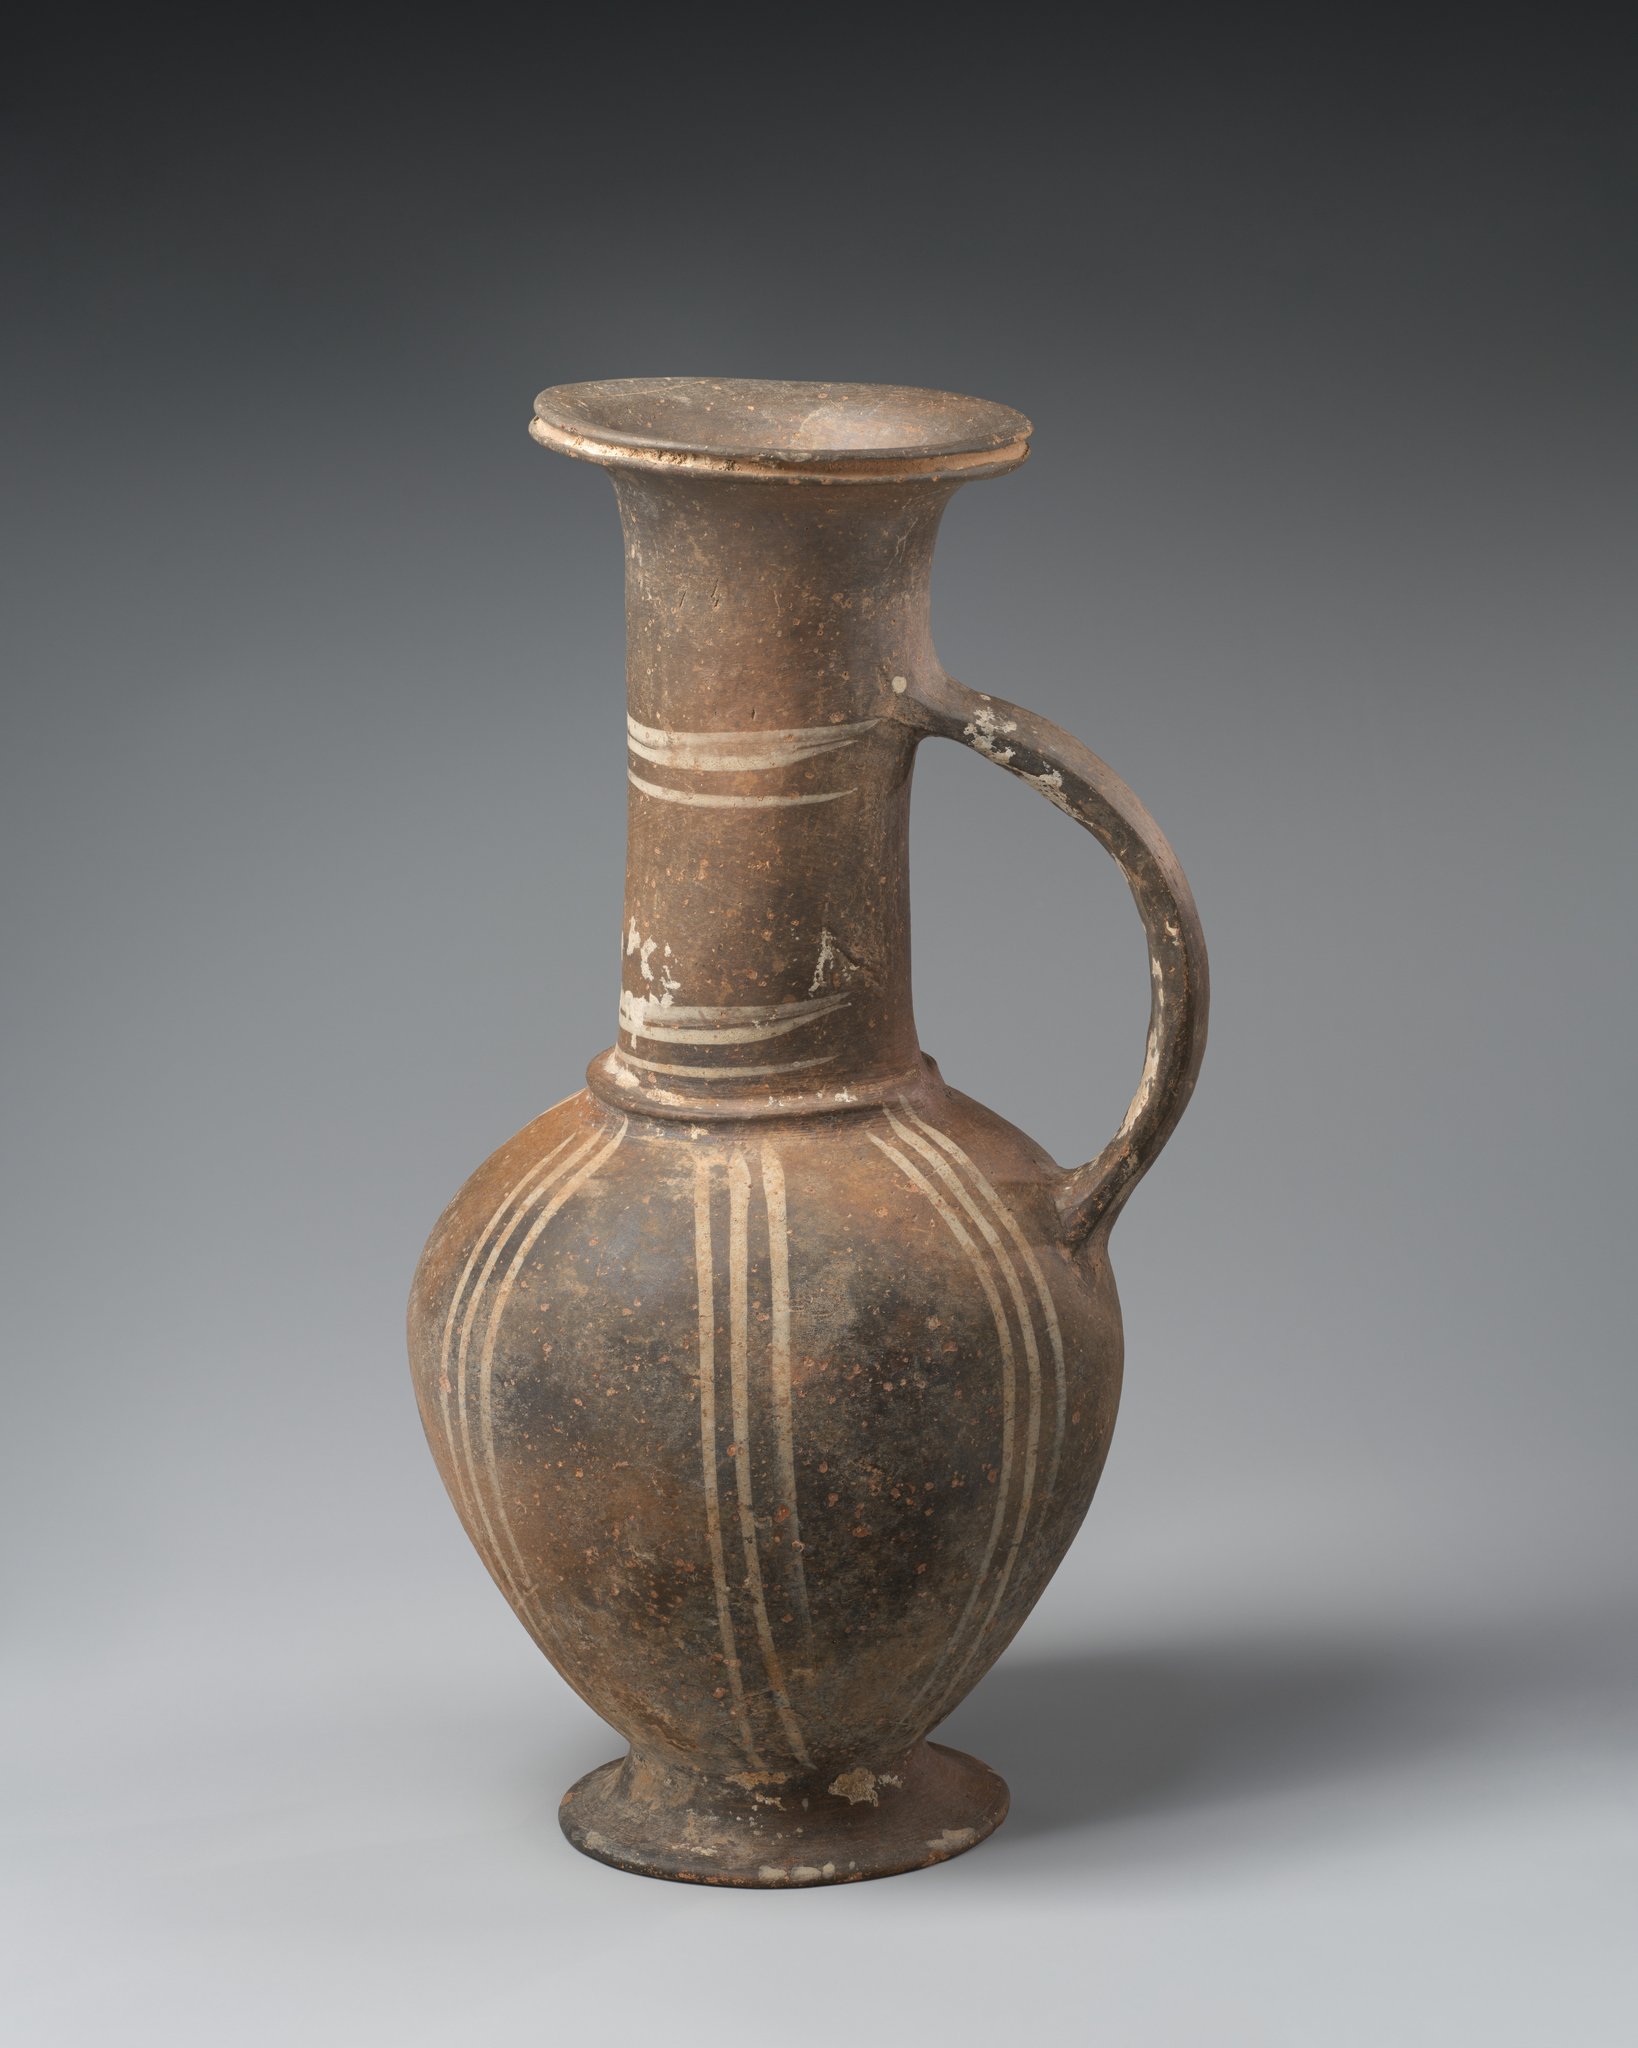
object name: jug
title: Terracotta jug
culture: cypriot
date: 1450-1200 BCE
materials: terracotta